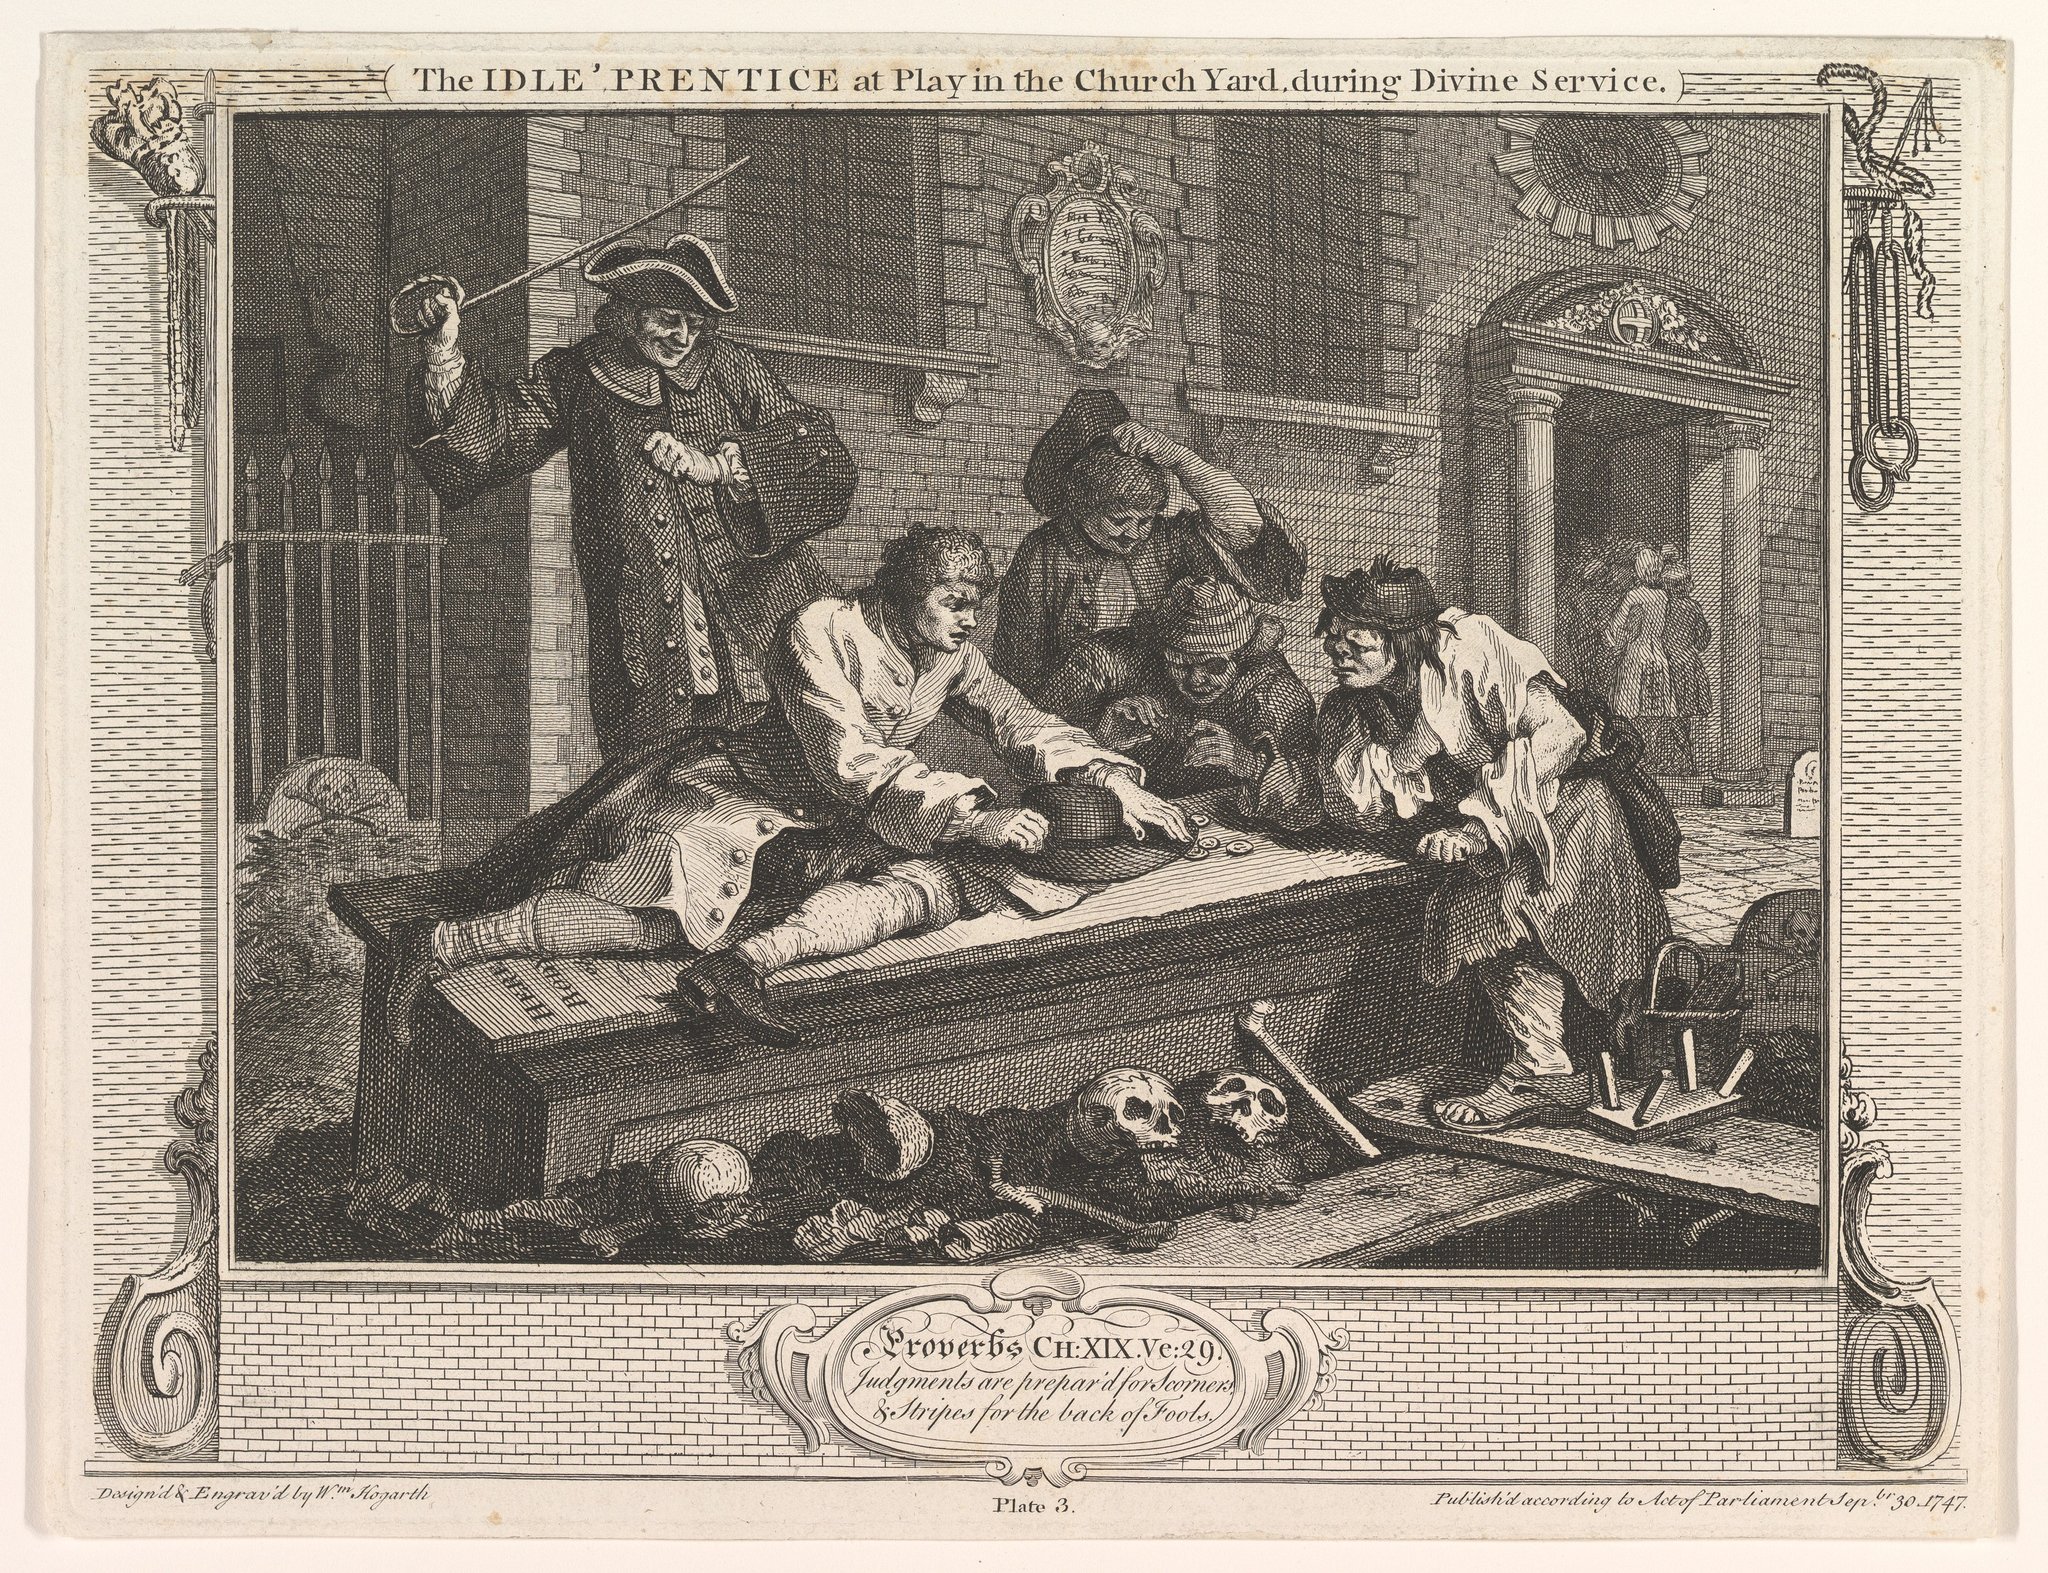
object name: print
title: The Idle 'Prentice at Play in the Church Yard (Industry and Idleness, plate 3)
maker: william hogarth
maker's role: artist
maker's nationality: british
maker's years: 1697-1764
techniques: engraving, etching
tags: buildings,skulls,men